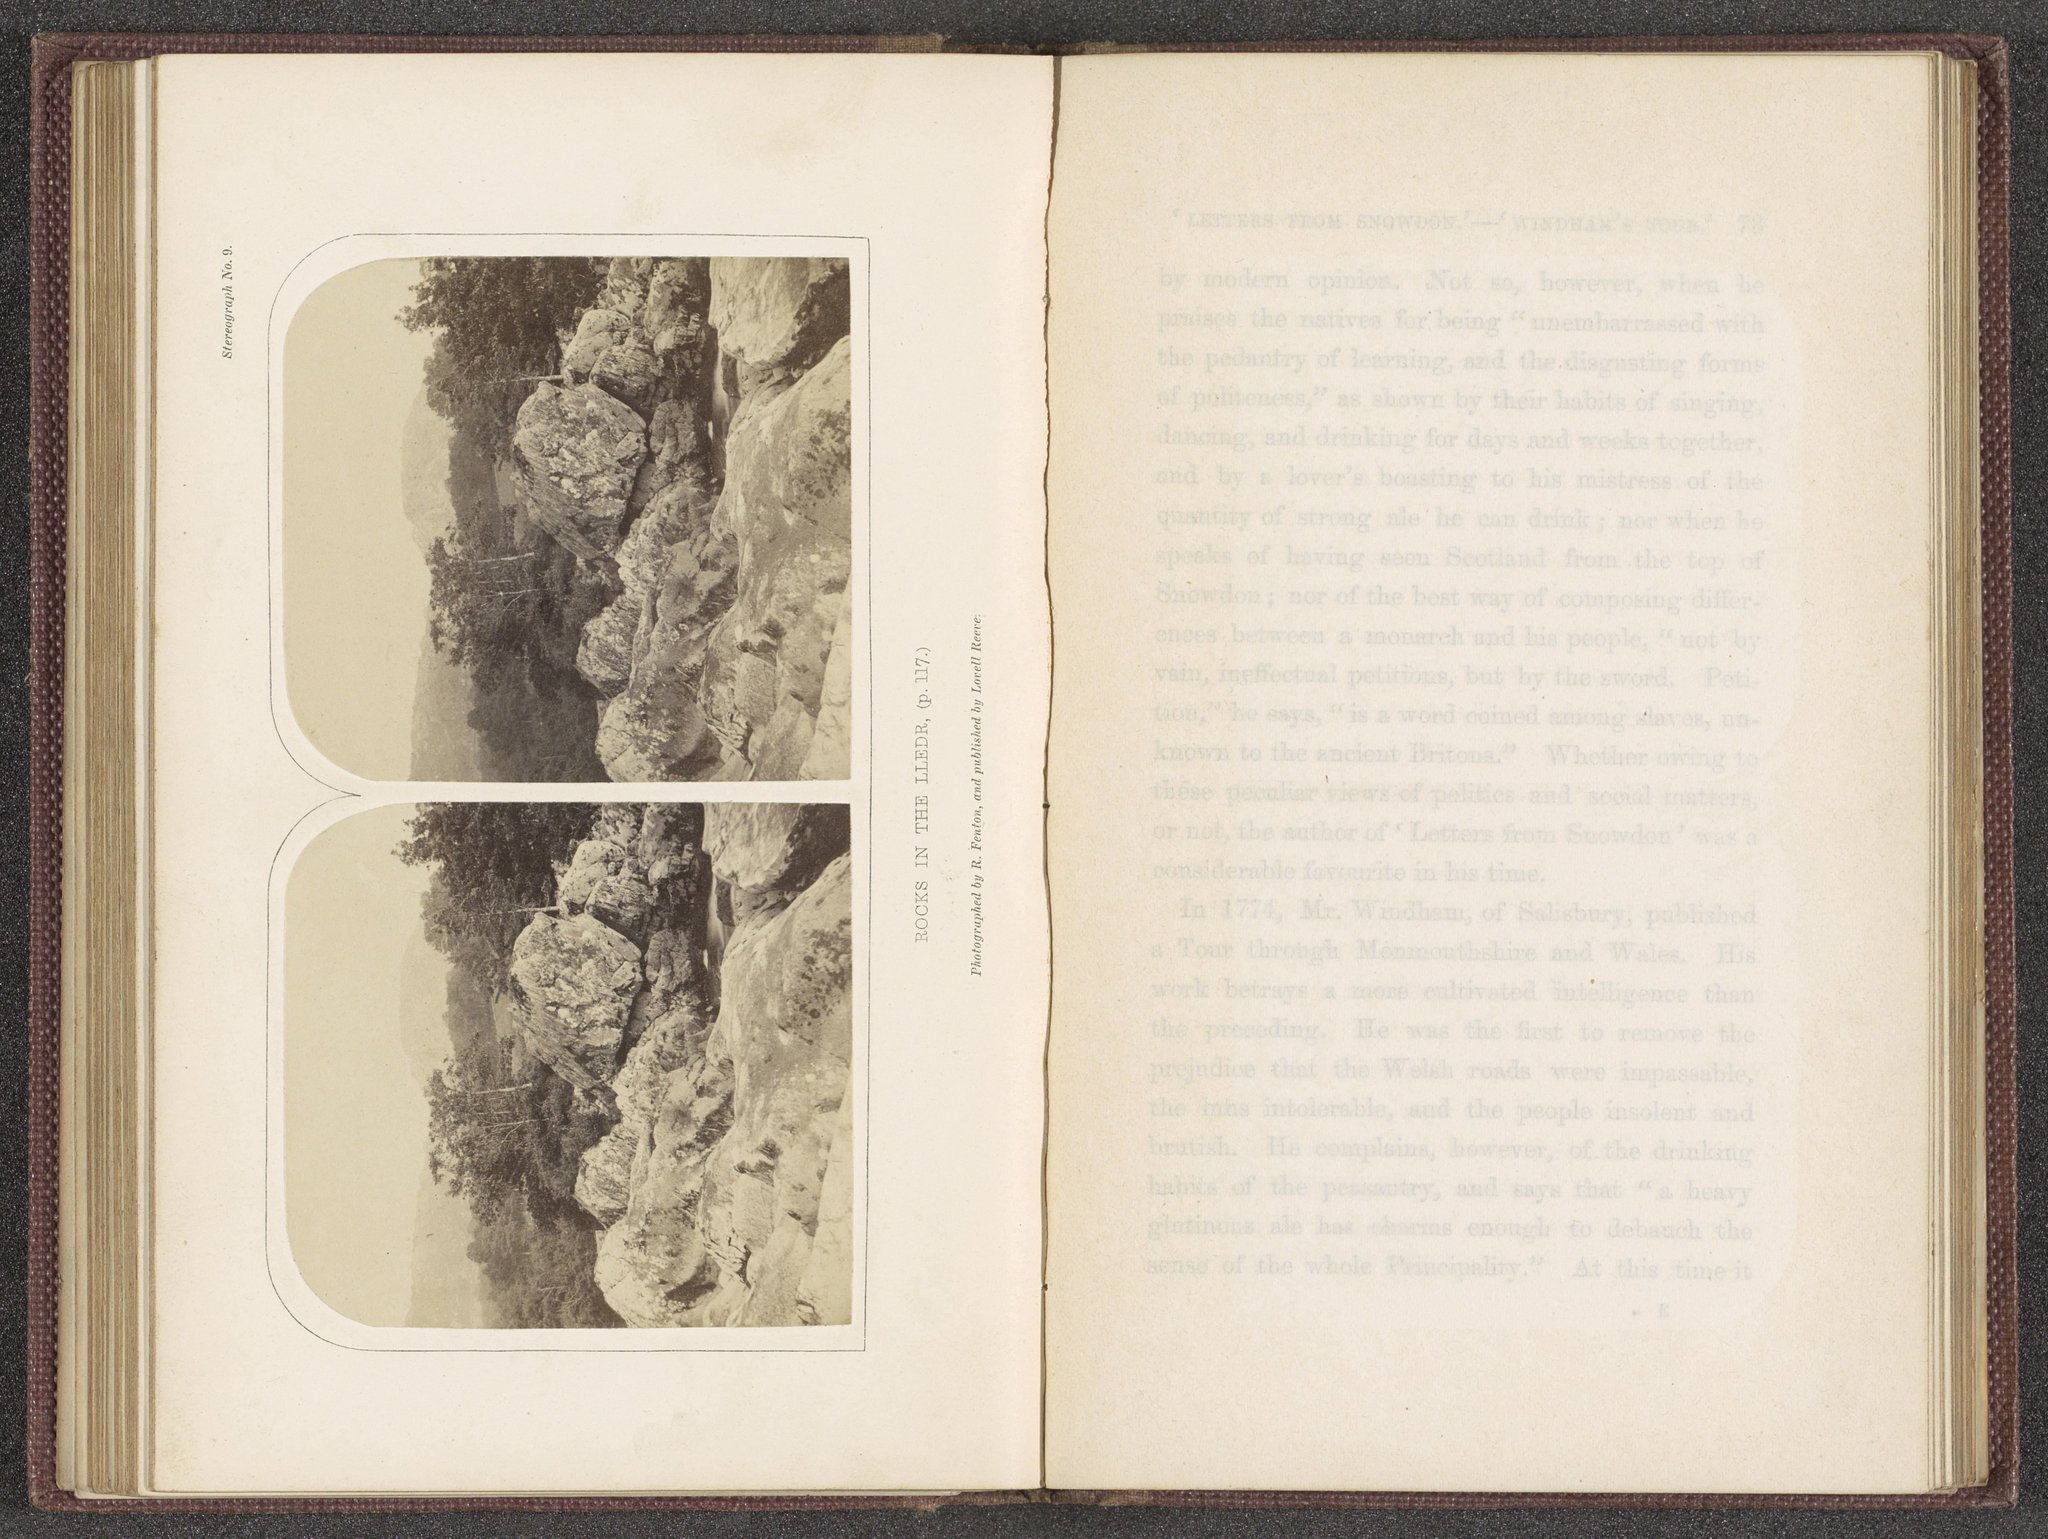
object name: page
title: Rocks in the Lledr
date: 1859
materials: paper, photographic support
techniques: albumen print, printing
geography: wales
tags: river, rocks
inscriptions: number: ‘Stereograph No. 9.’